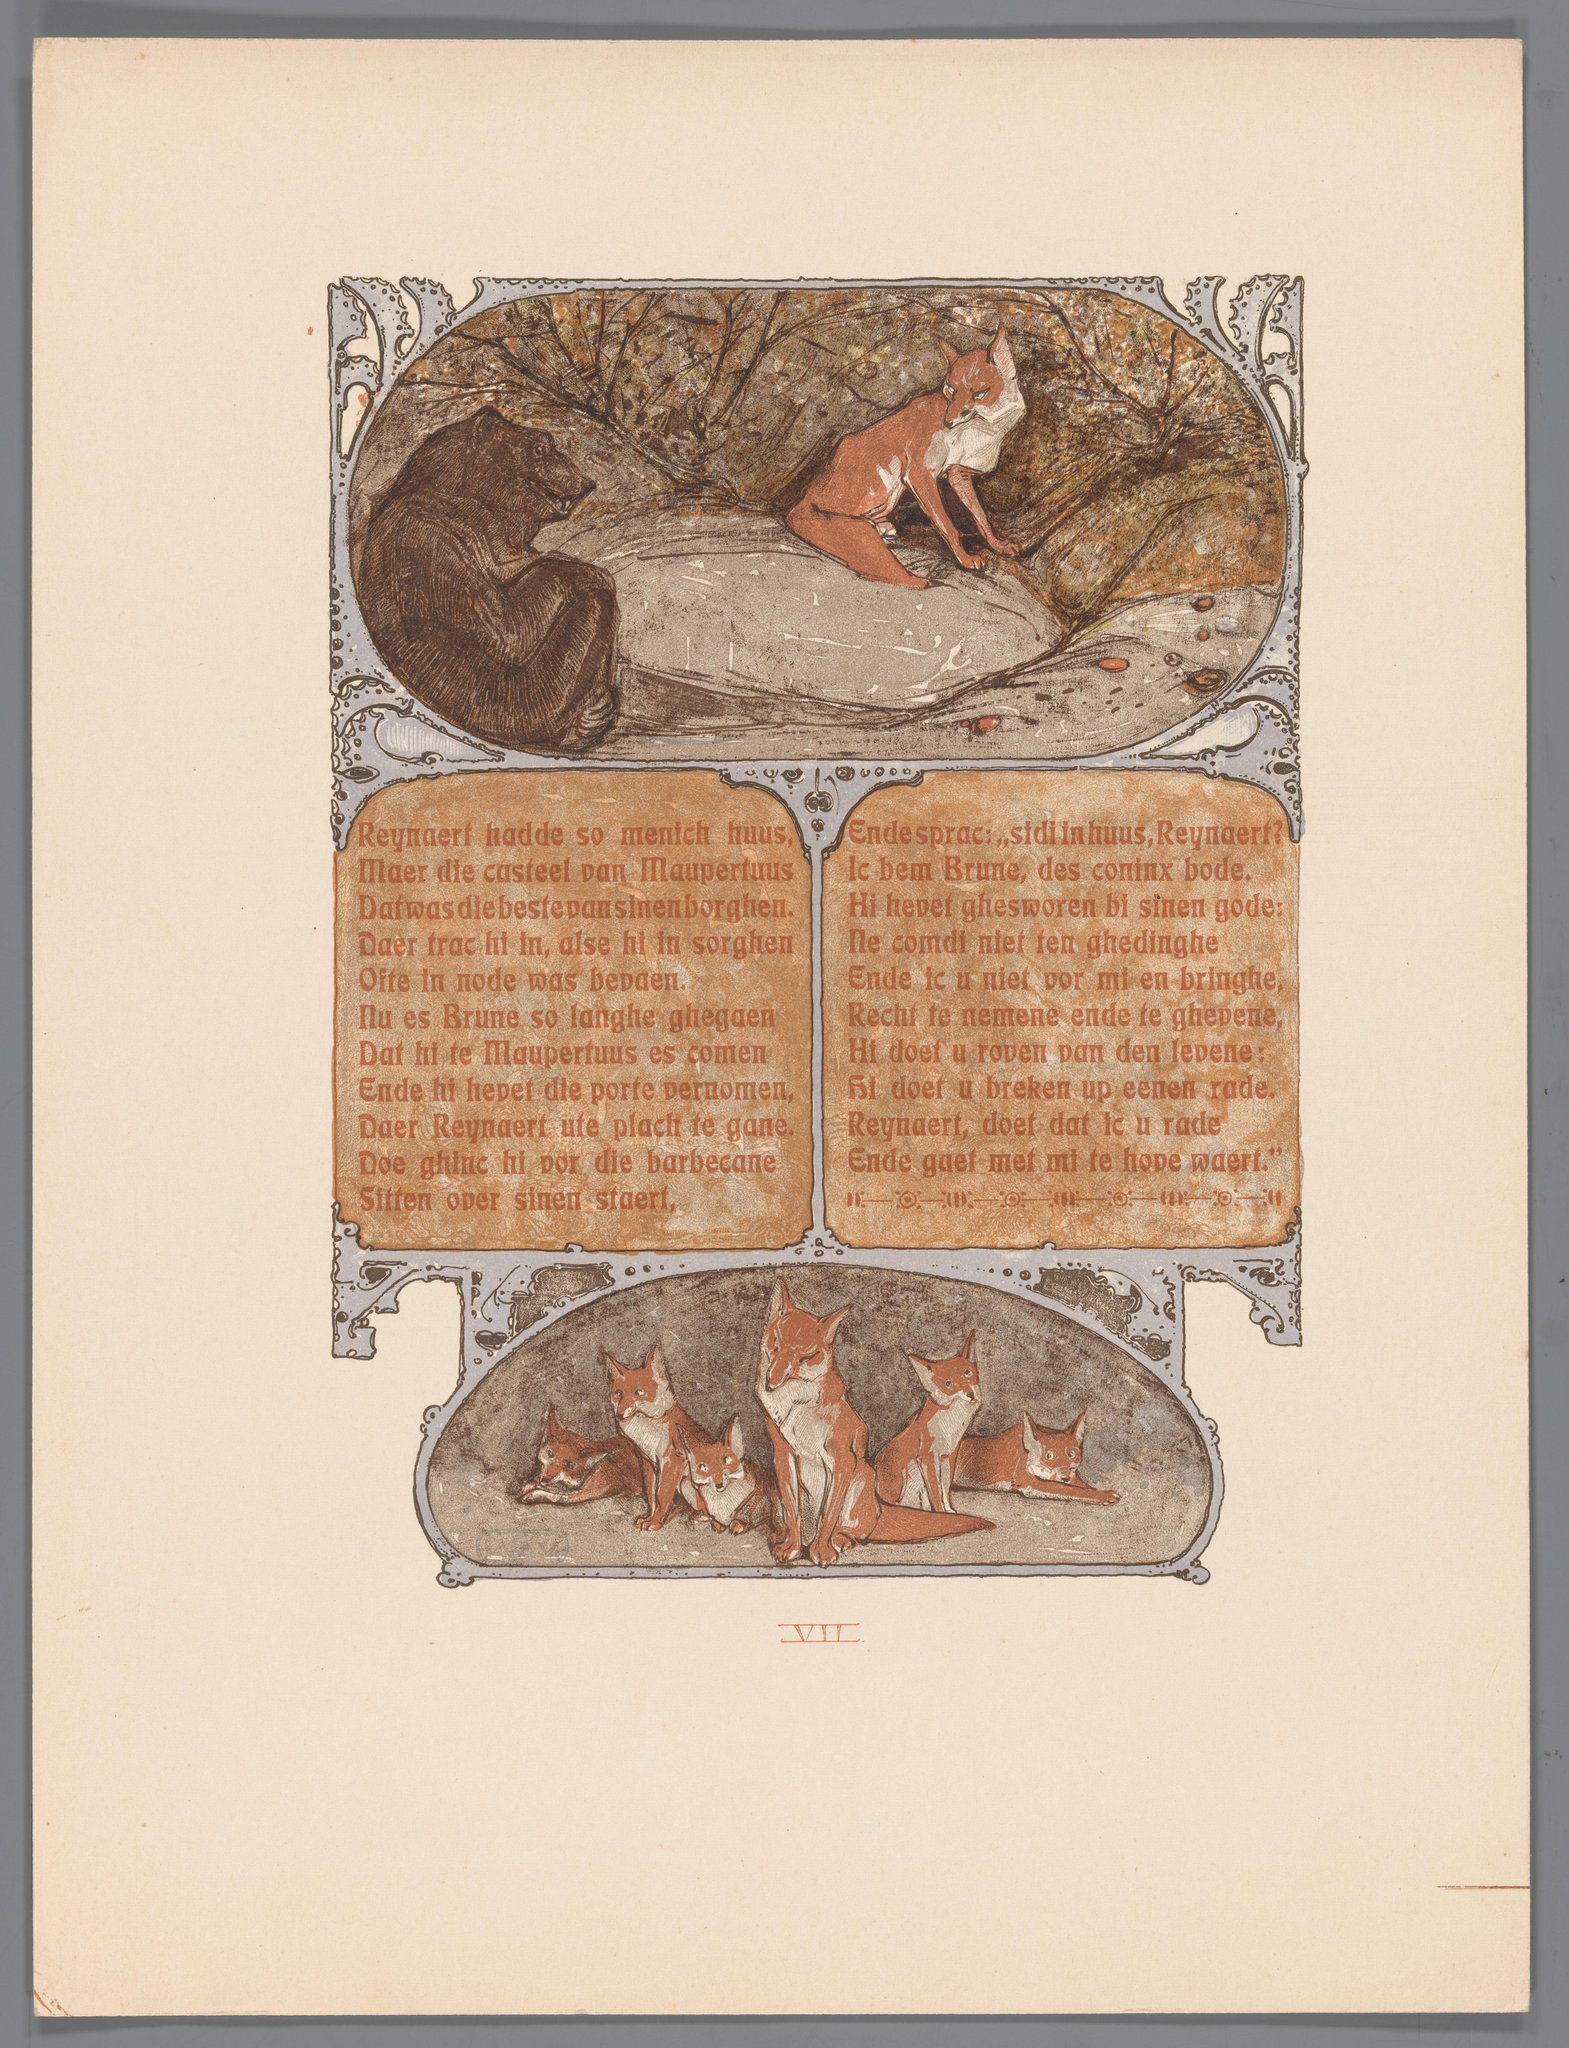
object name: book illustration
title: Beer (Bruun) en vos (Reinaert)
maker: bernard willem wierink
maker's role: draughtsman, print maker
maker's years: 1856-1939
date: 1910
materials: paper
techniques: lithograph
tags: fable of reynard the fox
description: Prent gebruikt in: Streuvels, Stijn (Frank Lateur). Reinaert de Vos naar verschillende uitgaven van het middeleeuwsche epos. Amsterdam: L.J. Veen, 1910.